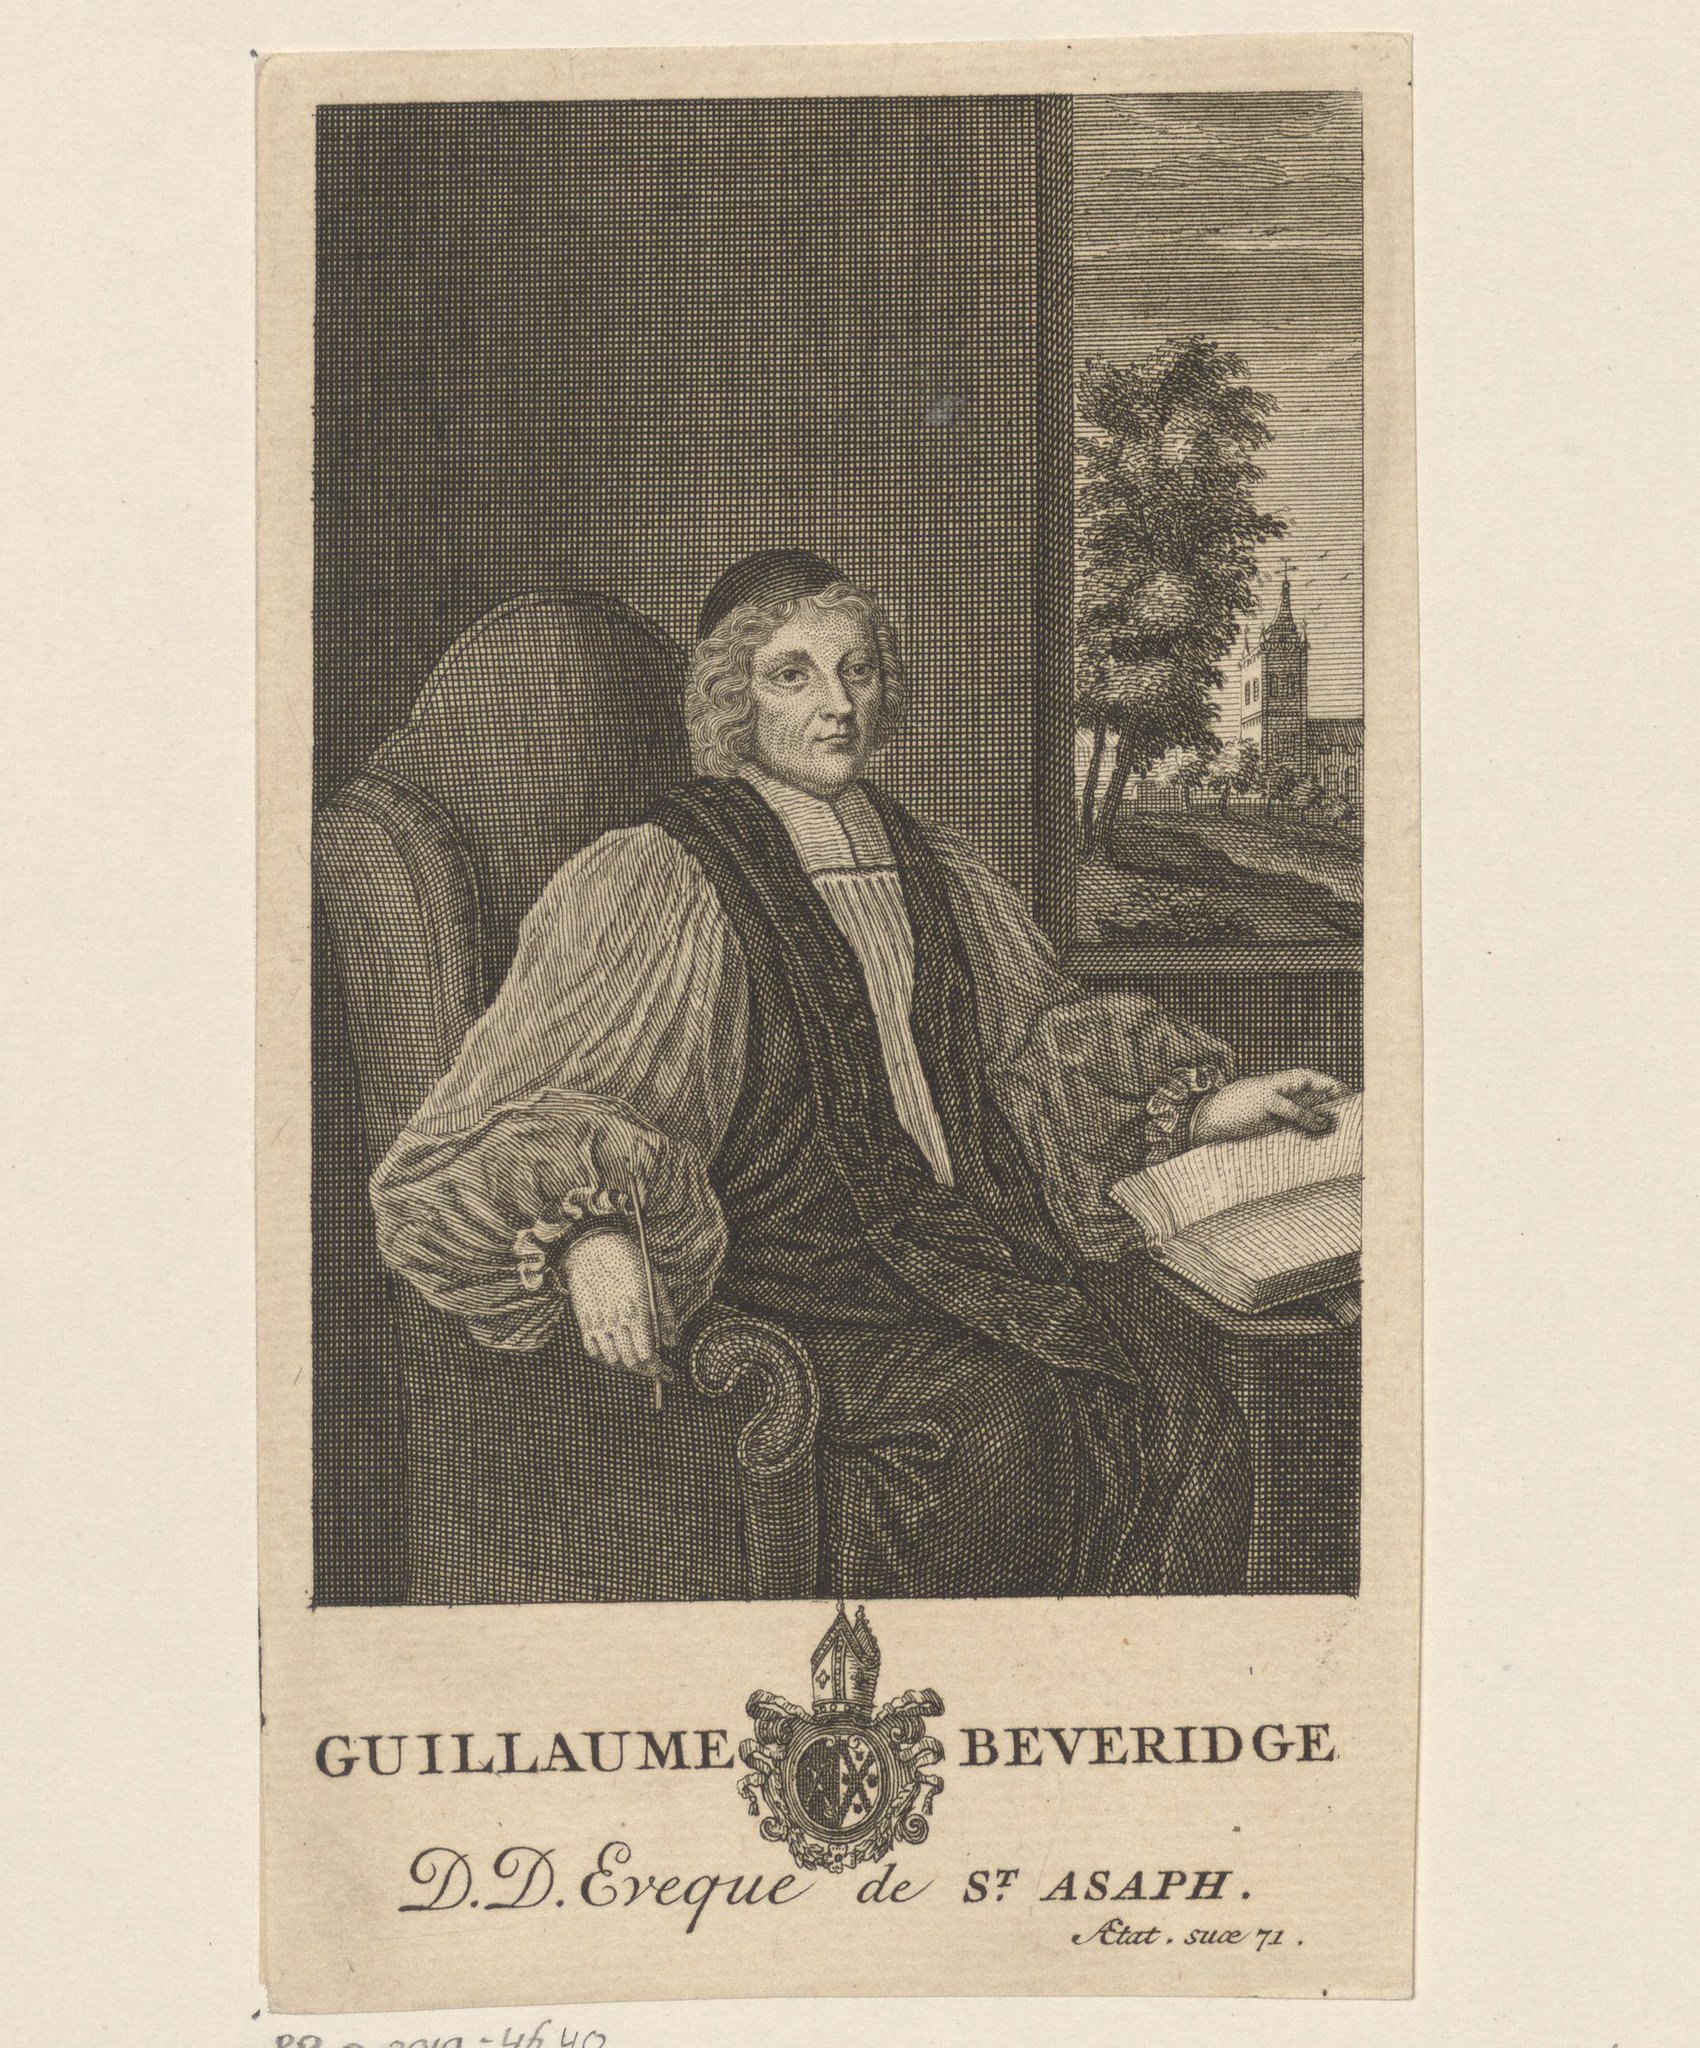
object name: book illustration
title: Portret van William Beveridge op 71-jarige leeftijd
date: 1731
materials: paper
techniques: etching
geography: amsterdam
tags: city-view, and landscape with man-made constructions, historical persons, book, armorial bearing, heraldry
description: Prent uit: Beveridge, William. Pensées secrètes, divisées en deux parties (...). Amsterdam: Rudolph en Jacobus Wetstein en William Smith, 1731, dl. 1.